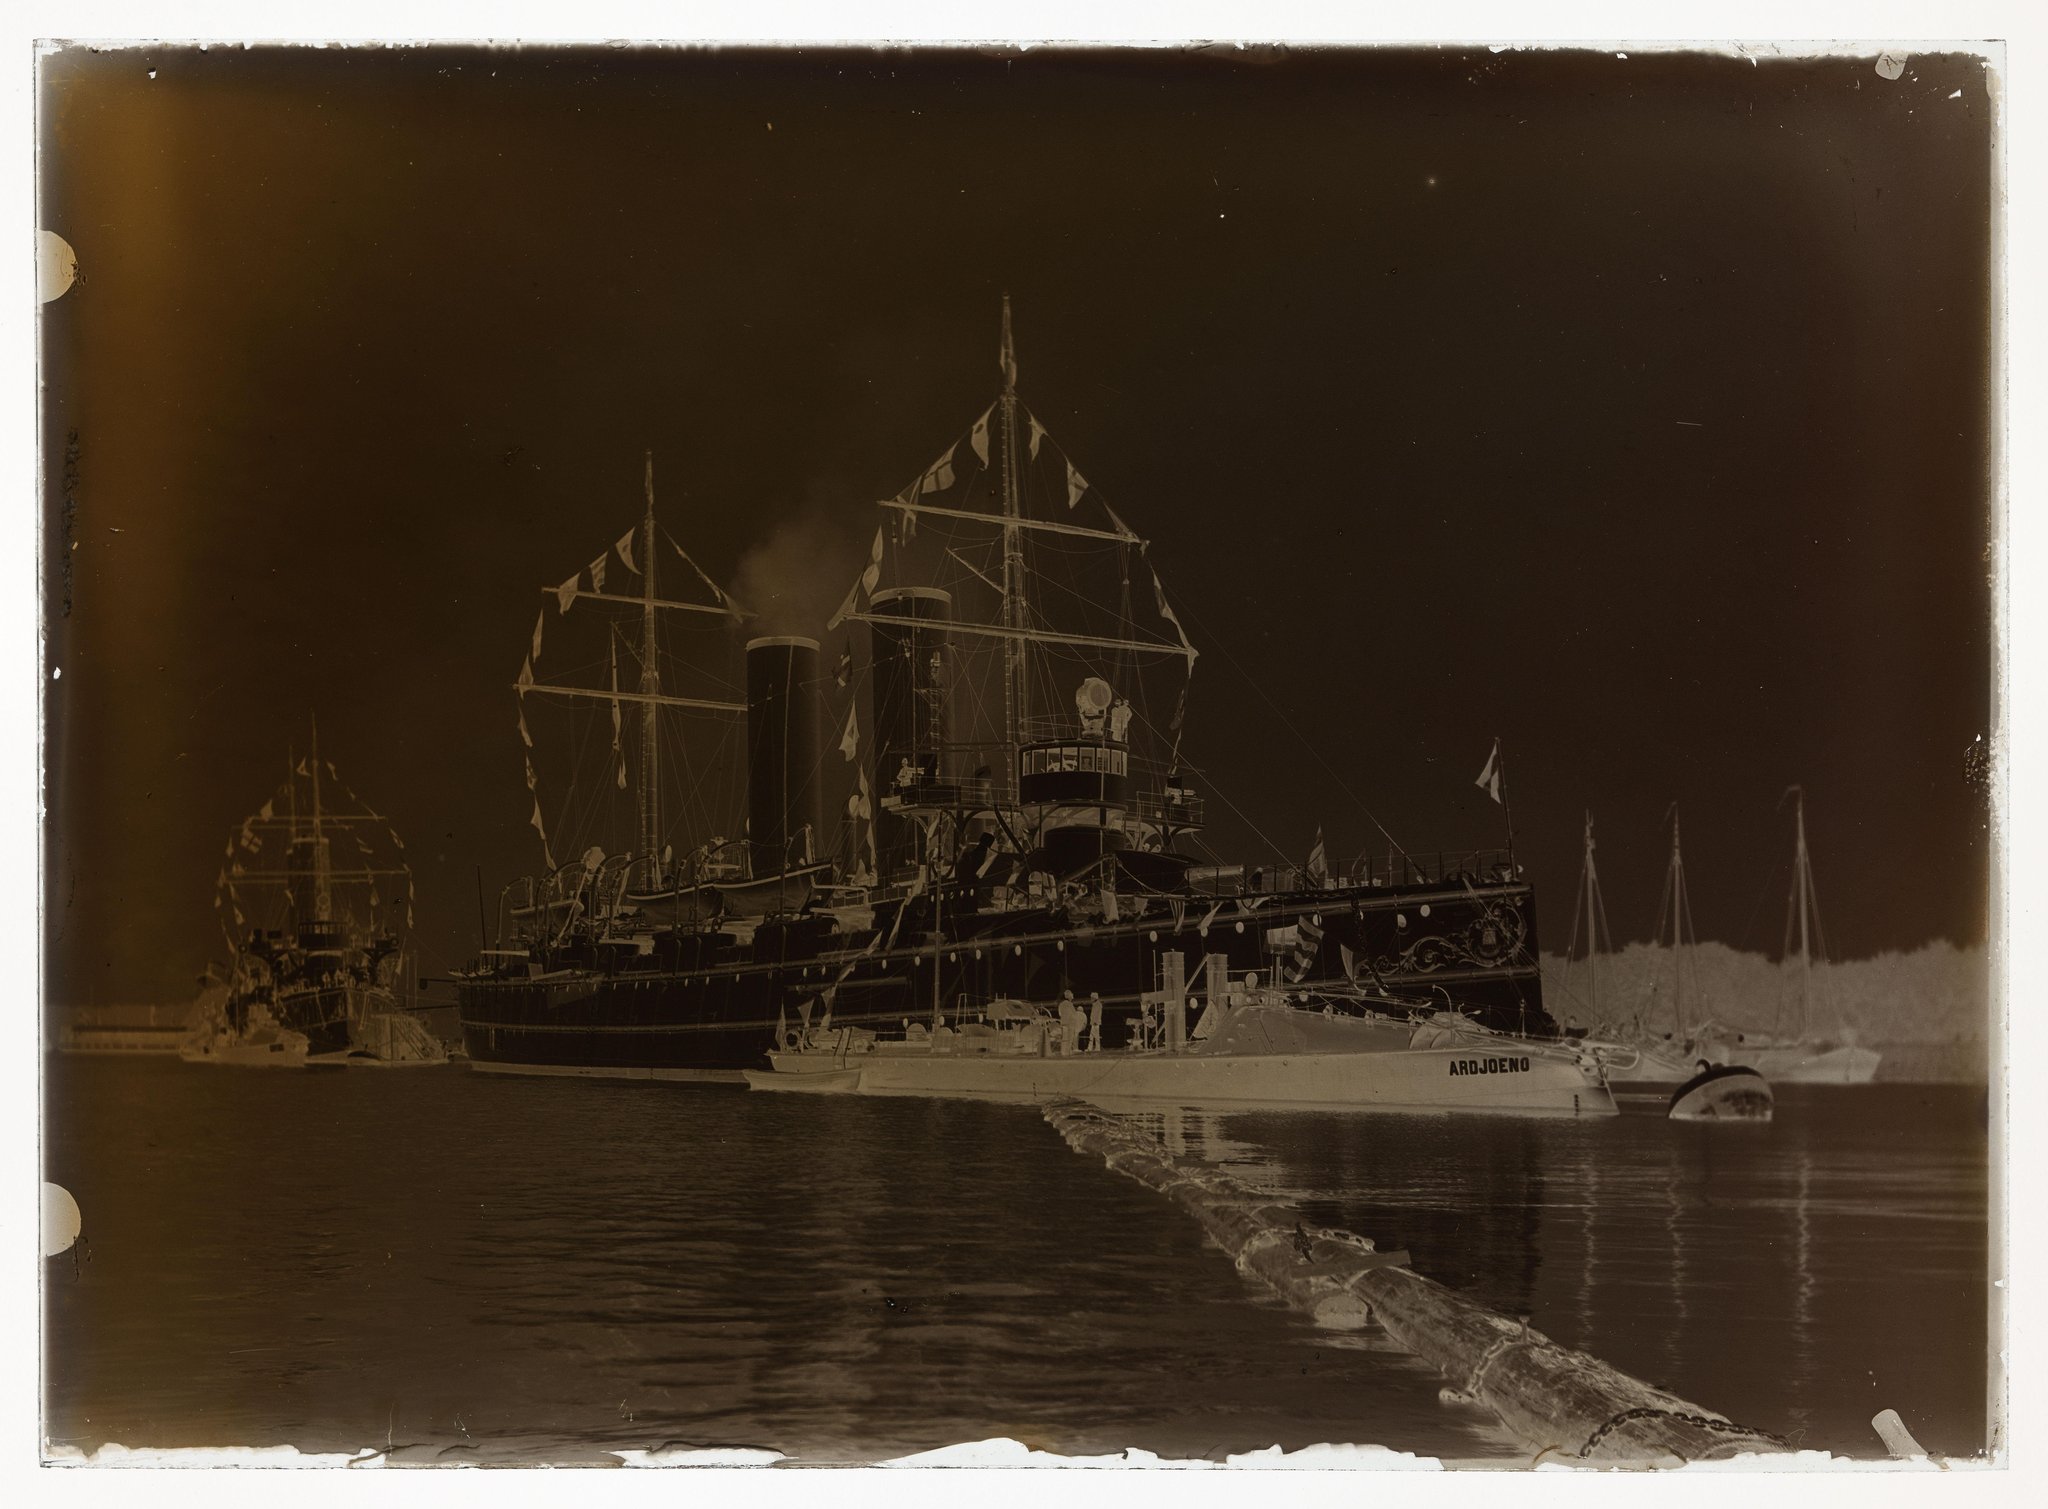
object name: glasnegatief, glasplaatnegatief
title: Twee grote stoomschepen met vlaggen en één klein stoomschip te water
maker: machiel gerrit george suyver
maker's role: fotograaf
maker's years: 1872-1933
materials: glass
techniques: gelatin glass negative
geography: netherlands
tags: the hague, print maker, wilhelmina of the netherlands, steamship, motorship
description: Torpedoschip Hr. Ms. Ardjoeno met daar achter pantserdekschepen Hr. Ms. Zeeland en Hr. Ms. Holland.